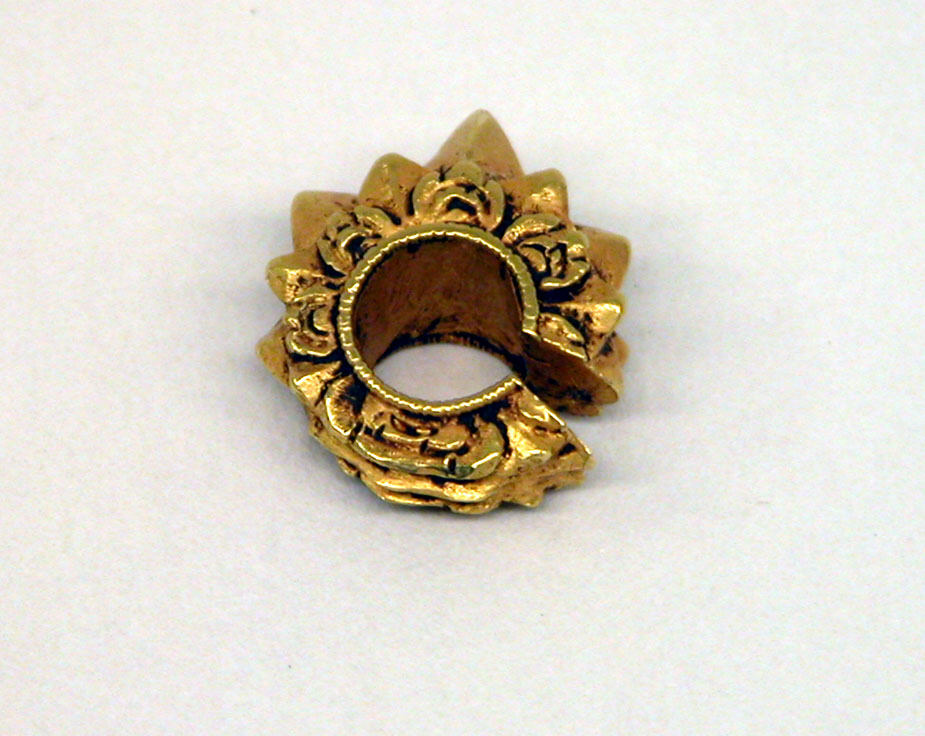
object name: ear clip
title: Ear Clip in the Shape of a Starfruit with Foliate Design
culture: indonesian, javanese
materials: gold